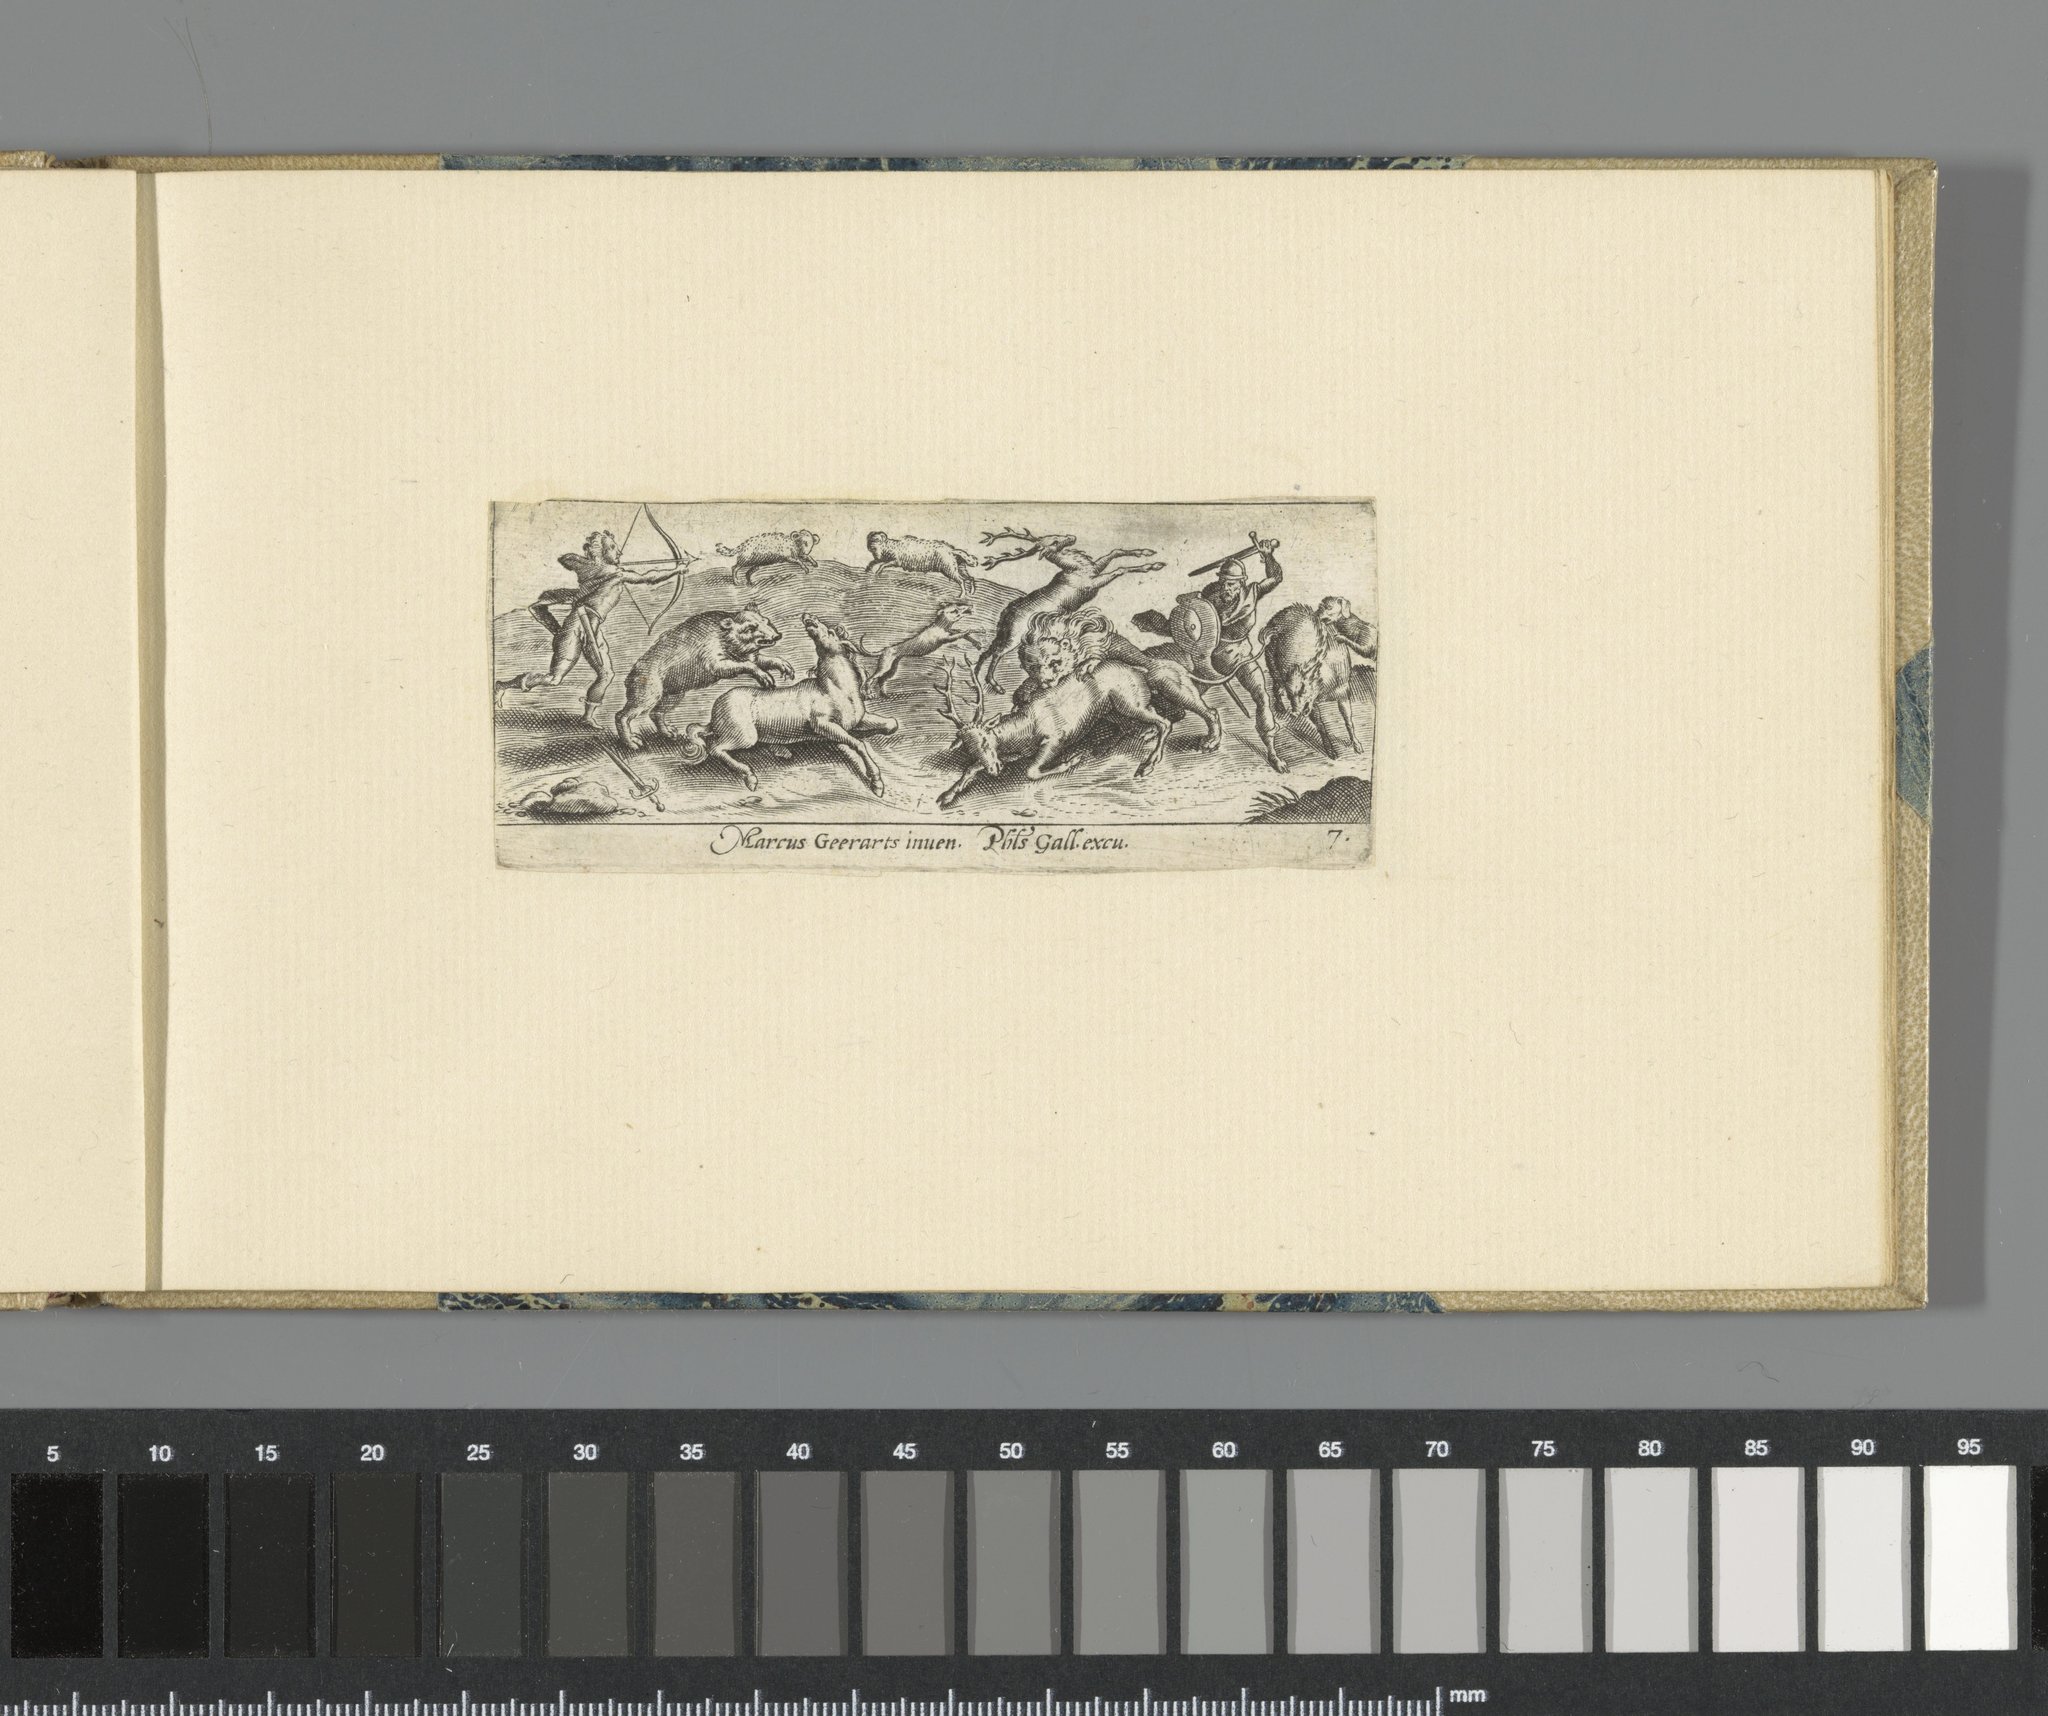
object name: album leaf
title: Landschap met jagers, beer, herten, leeuw en wild zwijn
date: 1570-1612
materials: paper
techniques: engraving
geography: antwerp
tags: hoofed animals: deer, game, hunted animals, beasts of prey, predatory animals: lion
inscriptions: collector's mark: Lugt 2228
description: Landschap met jagers, beer, herten, leeuw en wild zwijn. Deze prent maakt deel uit van een album.